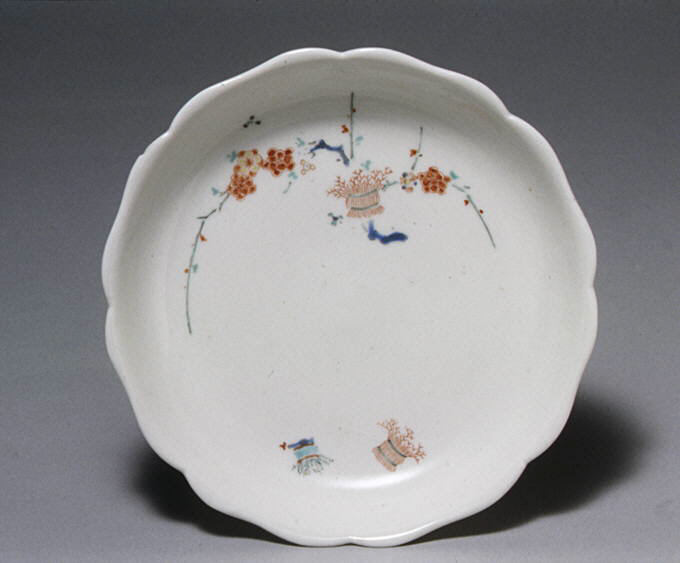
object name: saucer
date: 1725-1750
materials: hard paste porcelain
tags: flowers